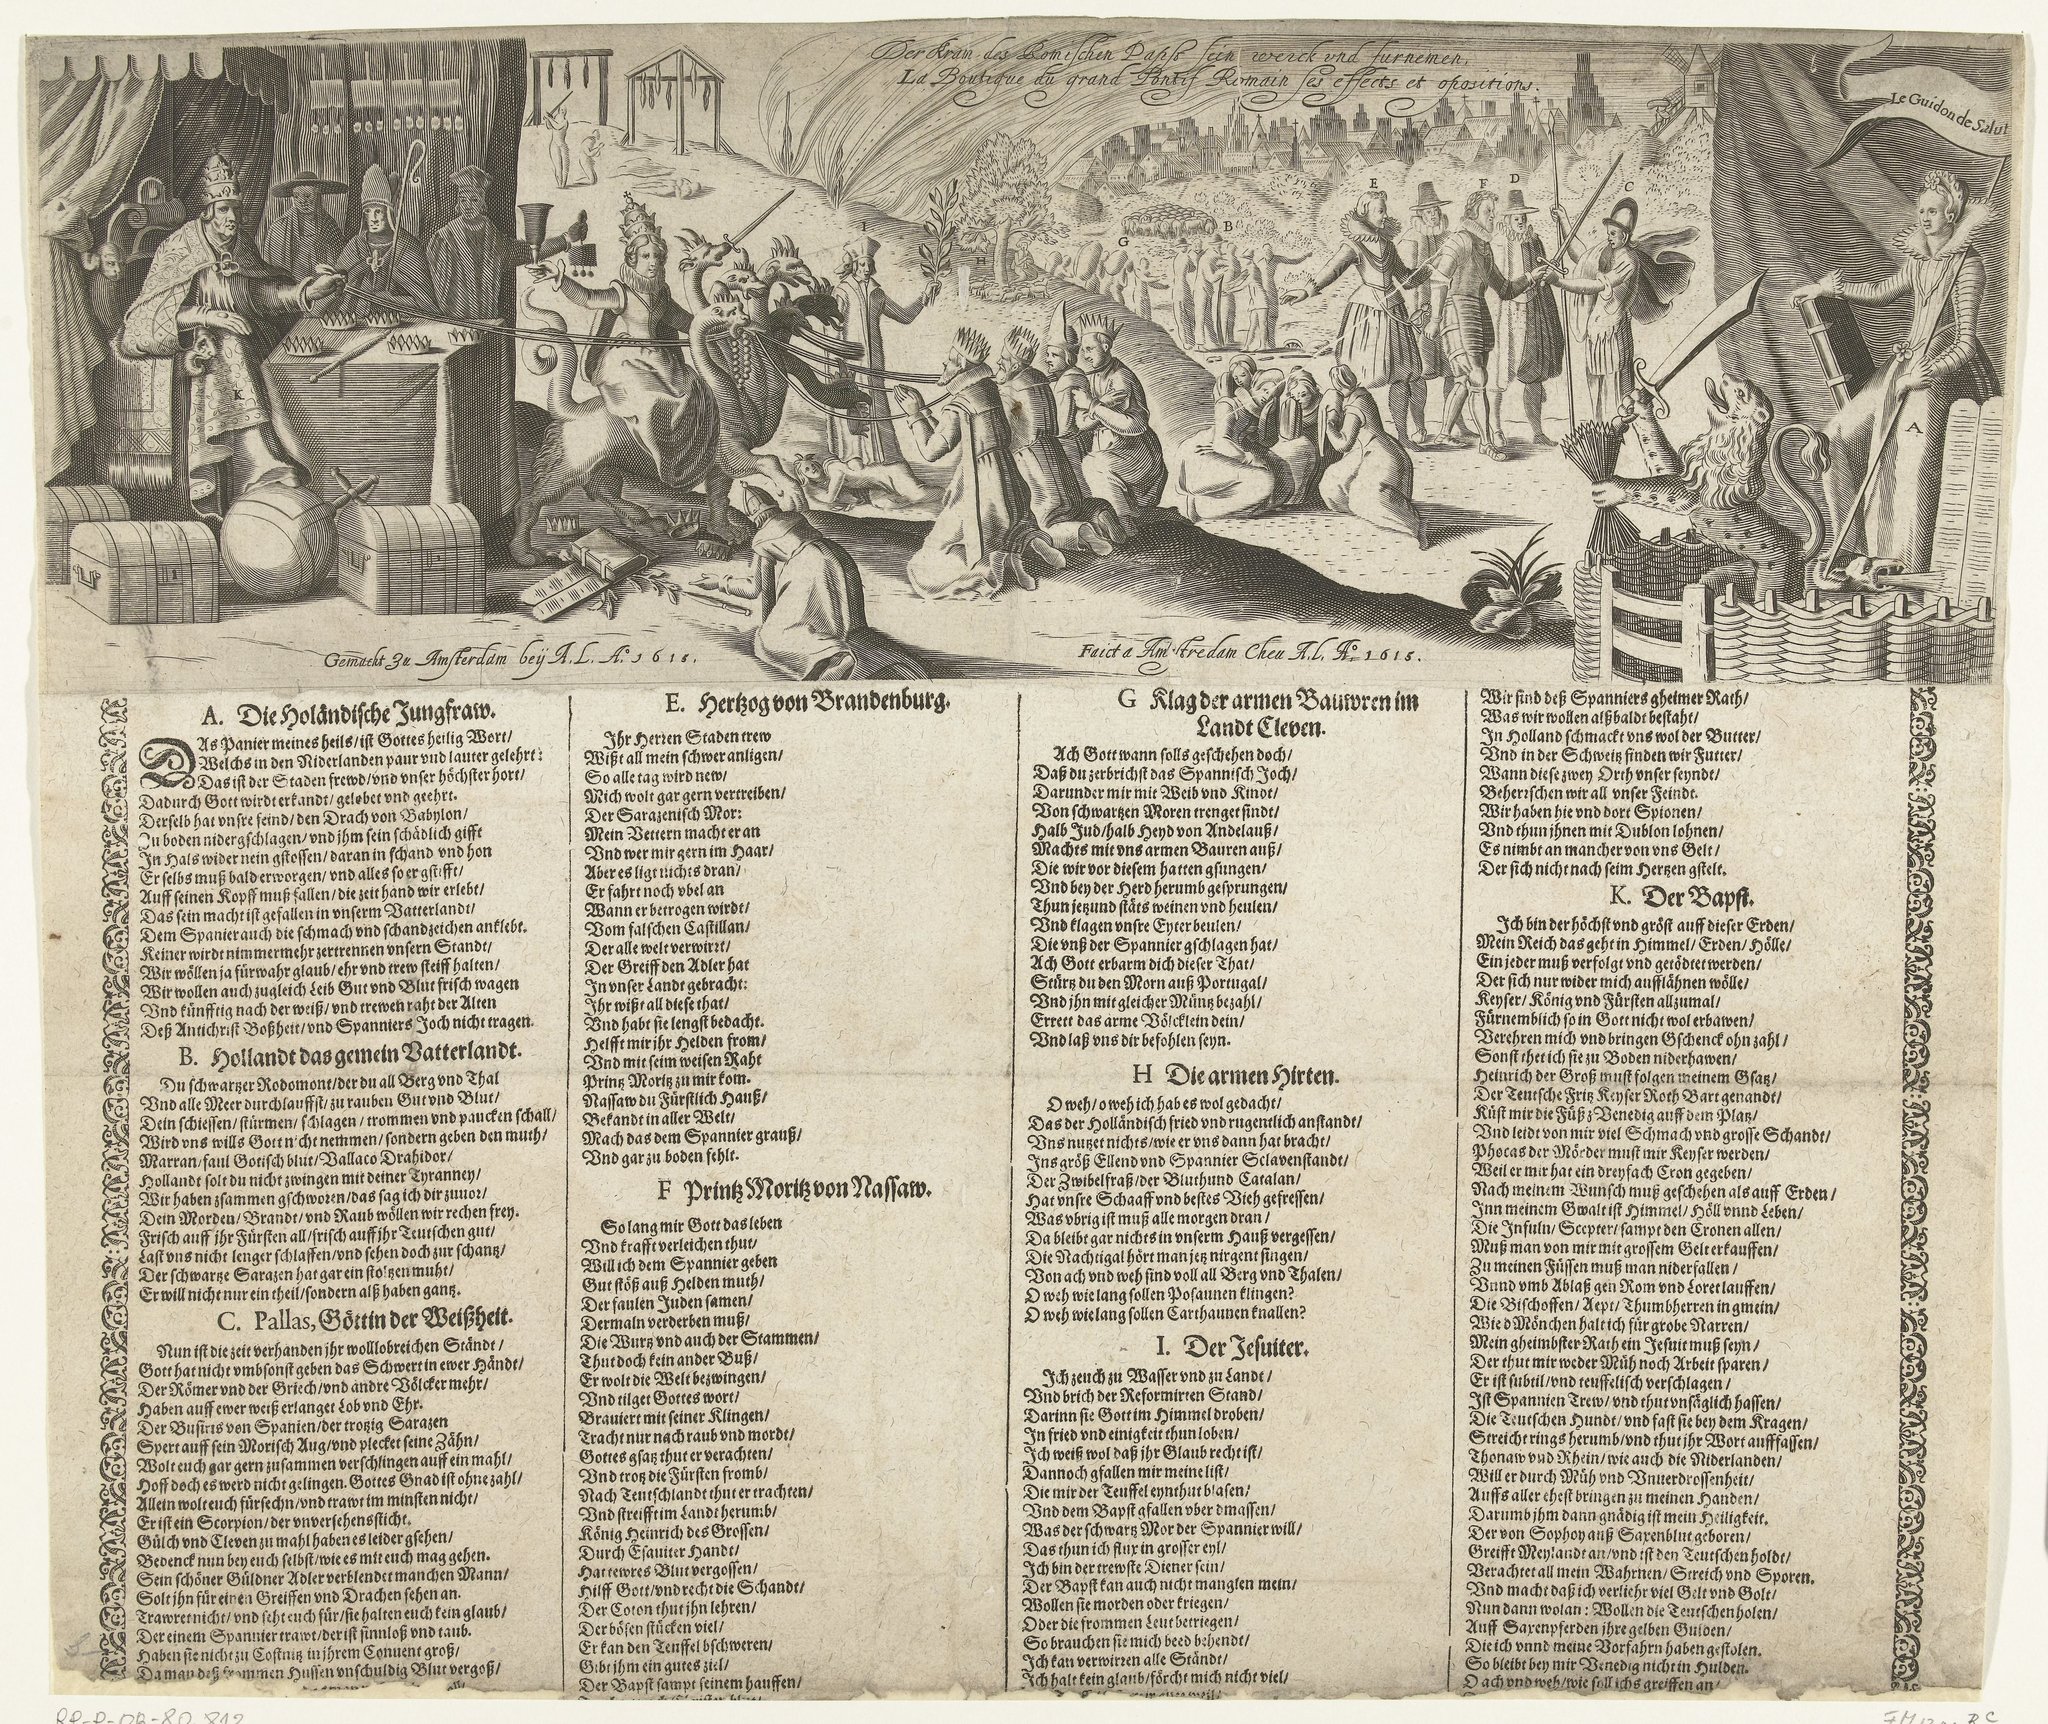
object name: print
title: De winkel van de paus van Rome, ca. 1615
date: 1615-1616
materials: paper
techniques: engraving, letterpress printing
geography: amsterdam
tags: maurice (prince of orange), wolfgang willem van de palts-neuburg, personifications of countries, nations, states, districts, etc., fenced or walled garden; 'hortus conclusus', execution of heretic, e.g. by burning at the stake, 'auto-da-fé', kissing the pope's feet, the scarlet woman, the whore of babylon; she is usually sitting on a scarlet beast with seven heads and ten horns, (allegory on) papacy and apostolic succession, netherlands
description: De winkel van de paus van Rome, ca. 1615. Allegorie op de onderdrukking door de katholieke kerk. Links zit de paus met aan een leiband de zevenkoppige draak met de hoer van Babylon en wereldse vorsten. Op de achtergronden ketterverbrandingen en terechtstellingen. Bij de voeten van de paus knielt keizer Barbarossa. Rechts de Nederlandse Maagd met de Hollandse Leeuw in de Hollandse Tuin. Pallas staat bij een groep van hervormde vorsten waaronder Maurits, de hertog van Brandenburg. Op de achtergrond de klagende boeren van Gulik en Kleef. In de tekst heeft ook Wolfgang Willem van de Palts-Neuburg een rol. Vastgeplakt onder de voorstelling een blad met 4 kolommen tekst in het Duits.